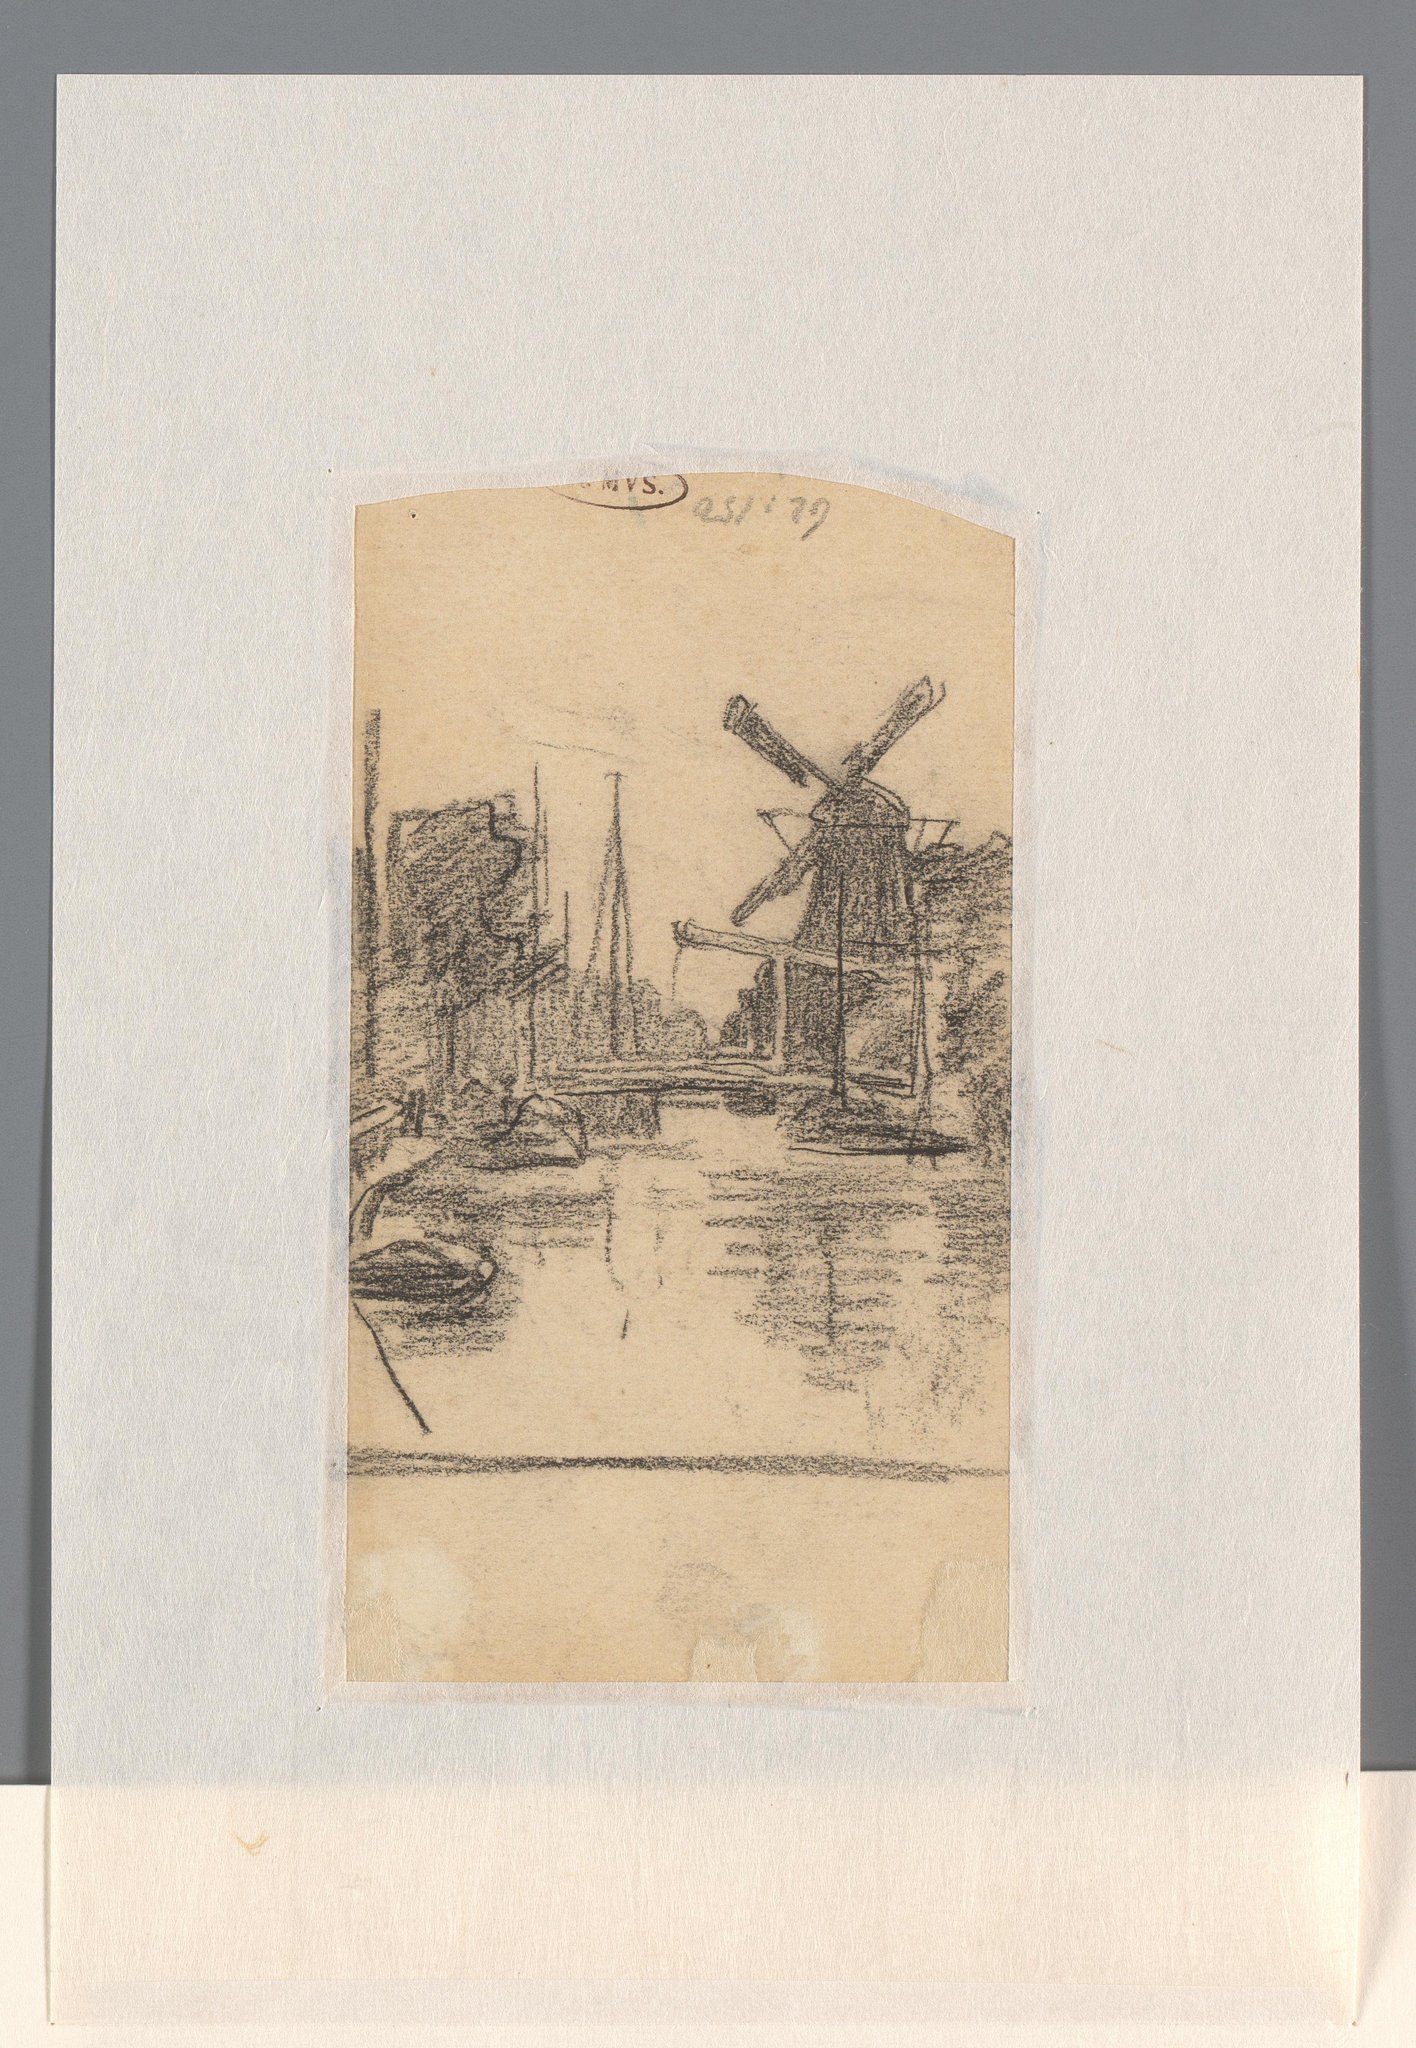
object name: drawing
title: Gracht met ophaalbrug en windmolen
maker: jan veth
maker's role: designer, draughtsman, painter, print maker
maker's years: 1864-1925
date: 1874-1925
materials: chalk, paper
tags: canals, waters (in city)